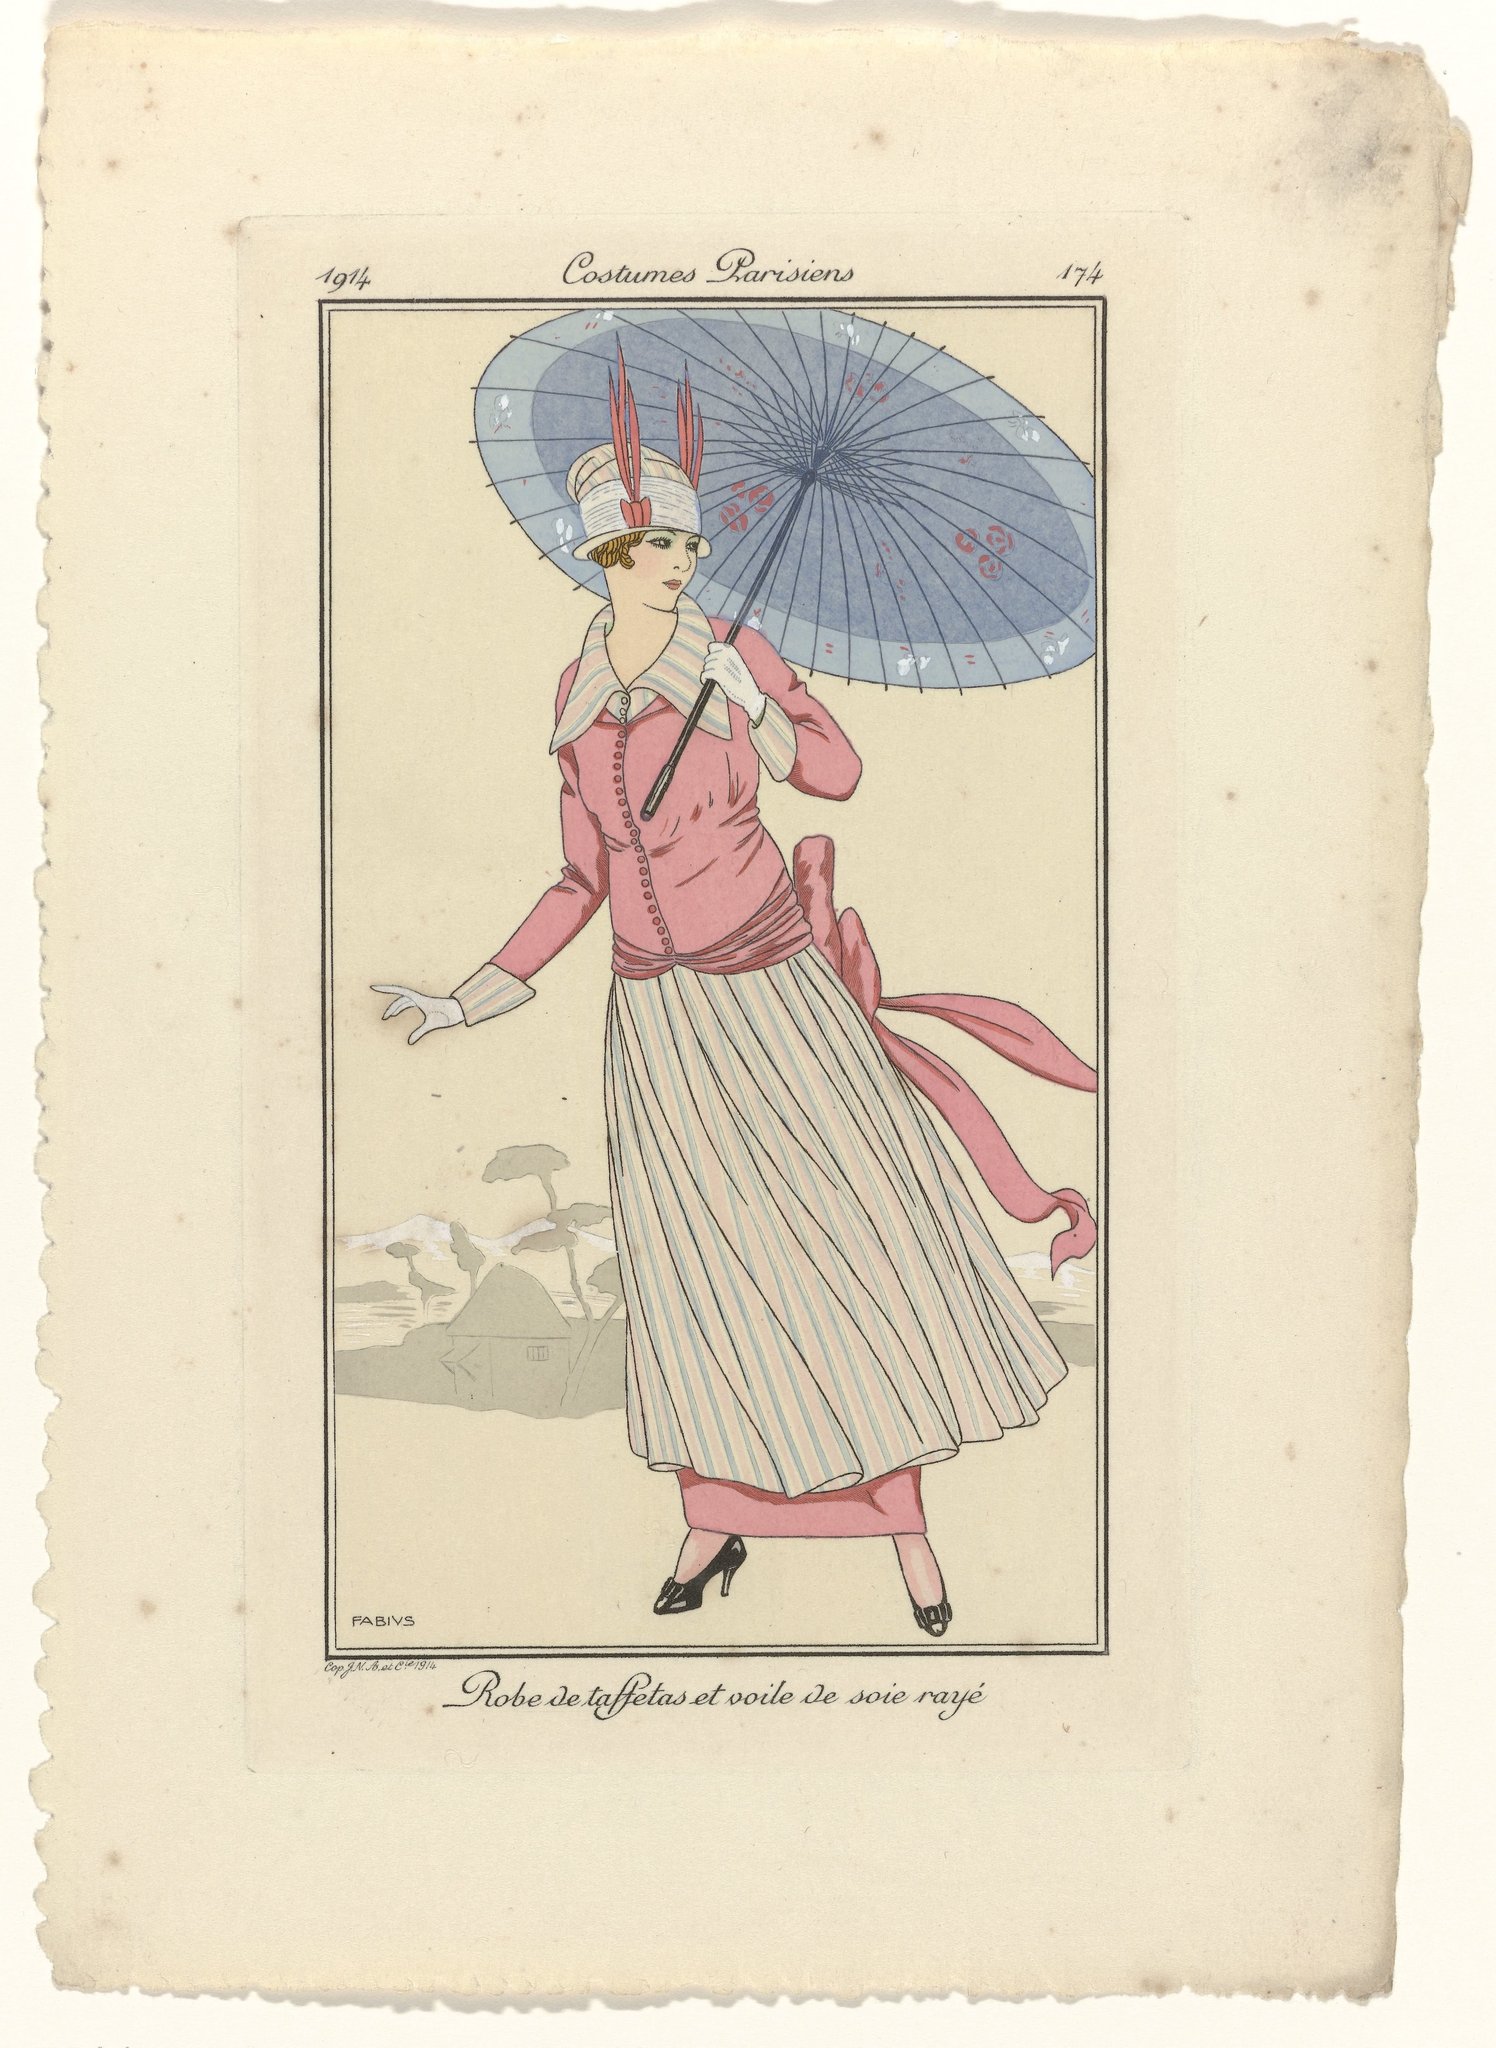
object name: fashion print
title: Journal des Dames et des Modes, Costumes Parisiens, 1914, No. 174 : Robe de taffetas (...)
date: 1914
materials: paper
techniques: engraving, hand coloring, pochoir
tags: fashion plates, head-gear: hat (+ women's clothes), dress, gown (+ women's clothes), parasol, sunshade (+ women's clothes)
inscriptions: caption: ‘Robe de taffetas et voile de soie rayé.’, inscription: ‘Cop. J. N. A. et Cie 1914’, title: ‘Costumes Parisiens’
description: Vrouw in een japon van tafzijde en gestreepte 'voile de soie'. Chinese of Japanse parasol in de hand. Prent uit het modetijdschrift Journal des Dames et des Modes (1912-1914).